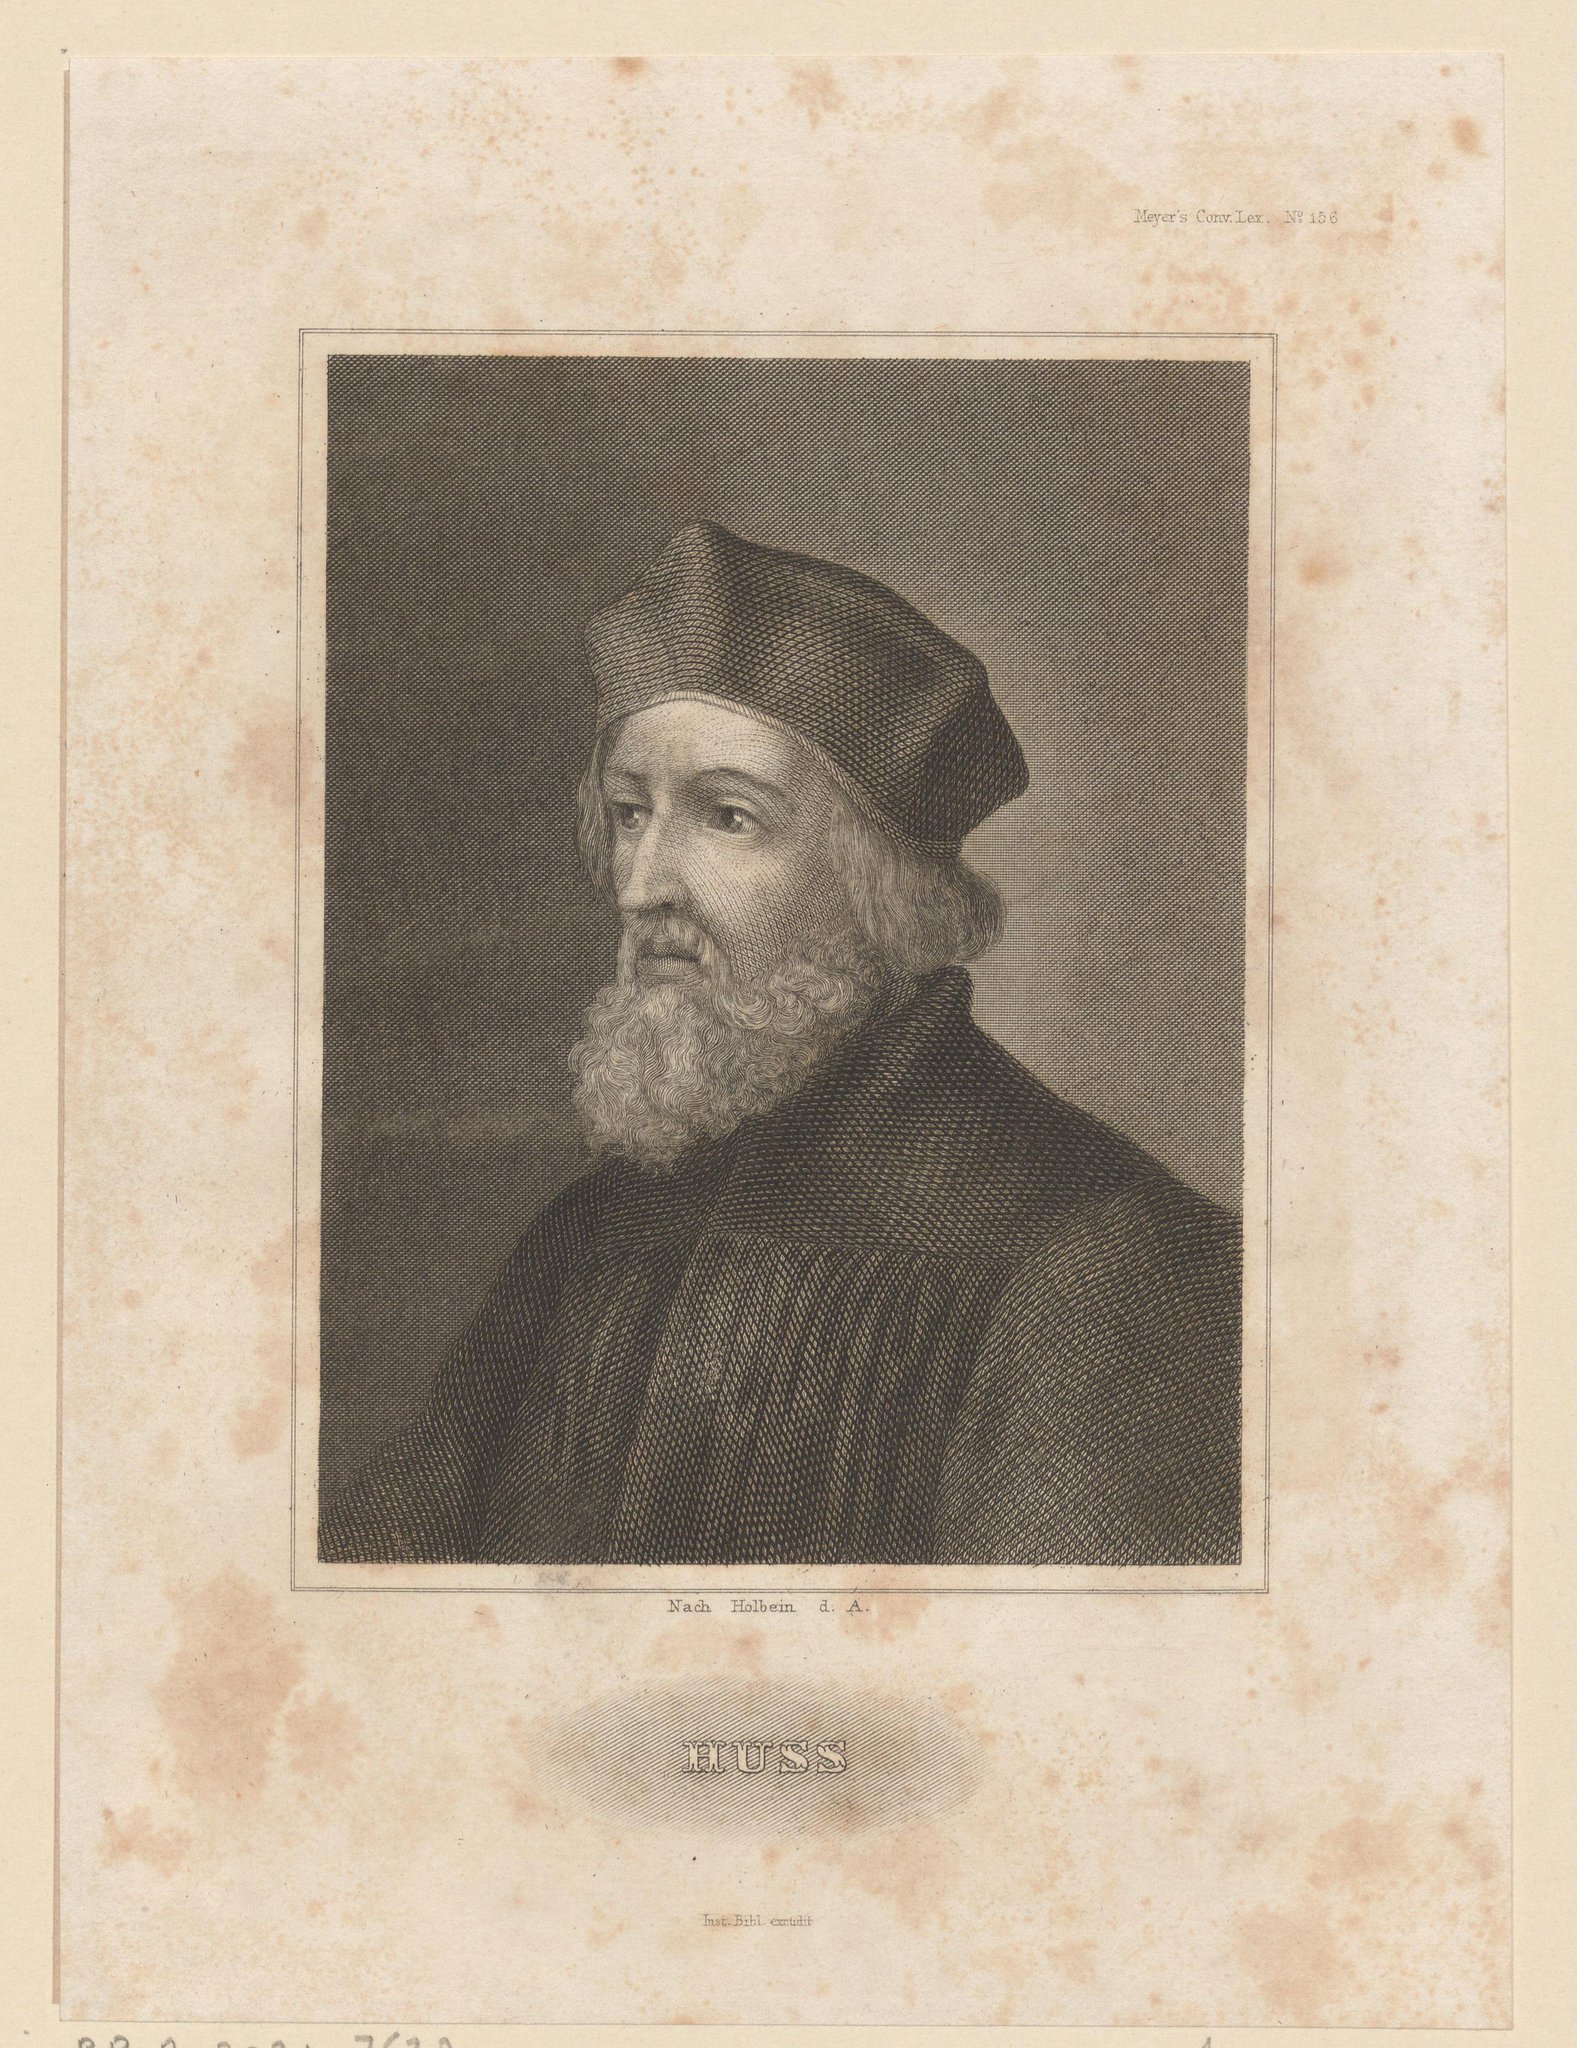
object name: print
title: Portret van Johannes Hus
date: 1840-1855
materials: paper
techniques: engraving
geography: hildburghausen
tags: theologian, historical persons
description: Prent uit: Meyer, Joseph. Das Grosse Conversations-Lexikon für die gebildeten Stände. Hildburghausen: Bibliographisches Institut, 1840-1855.